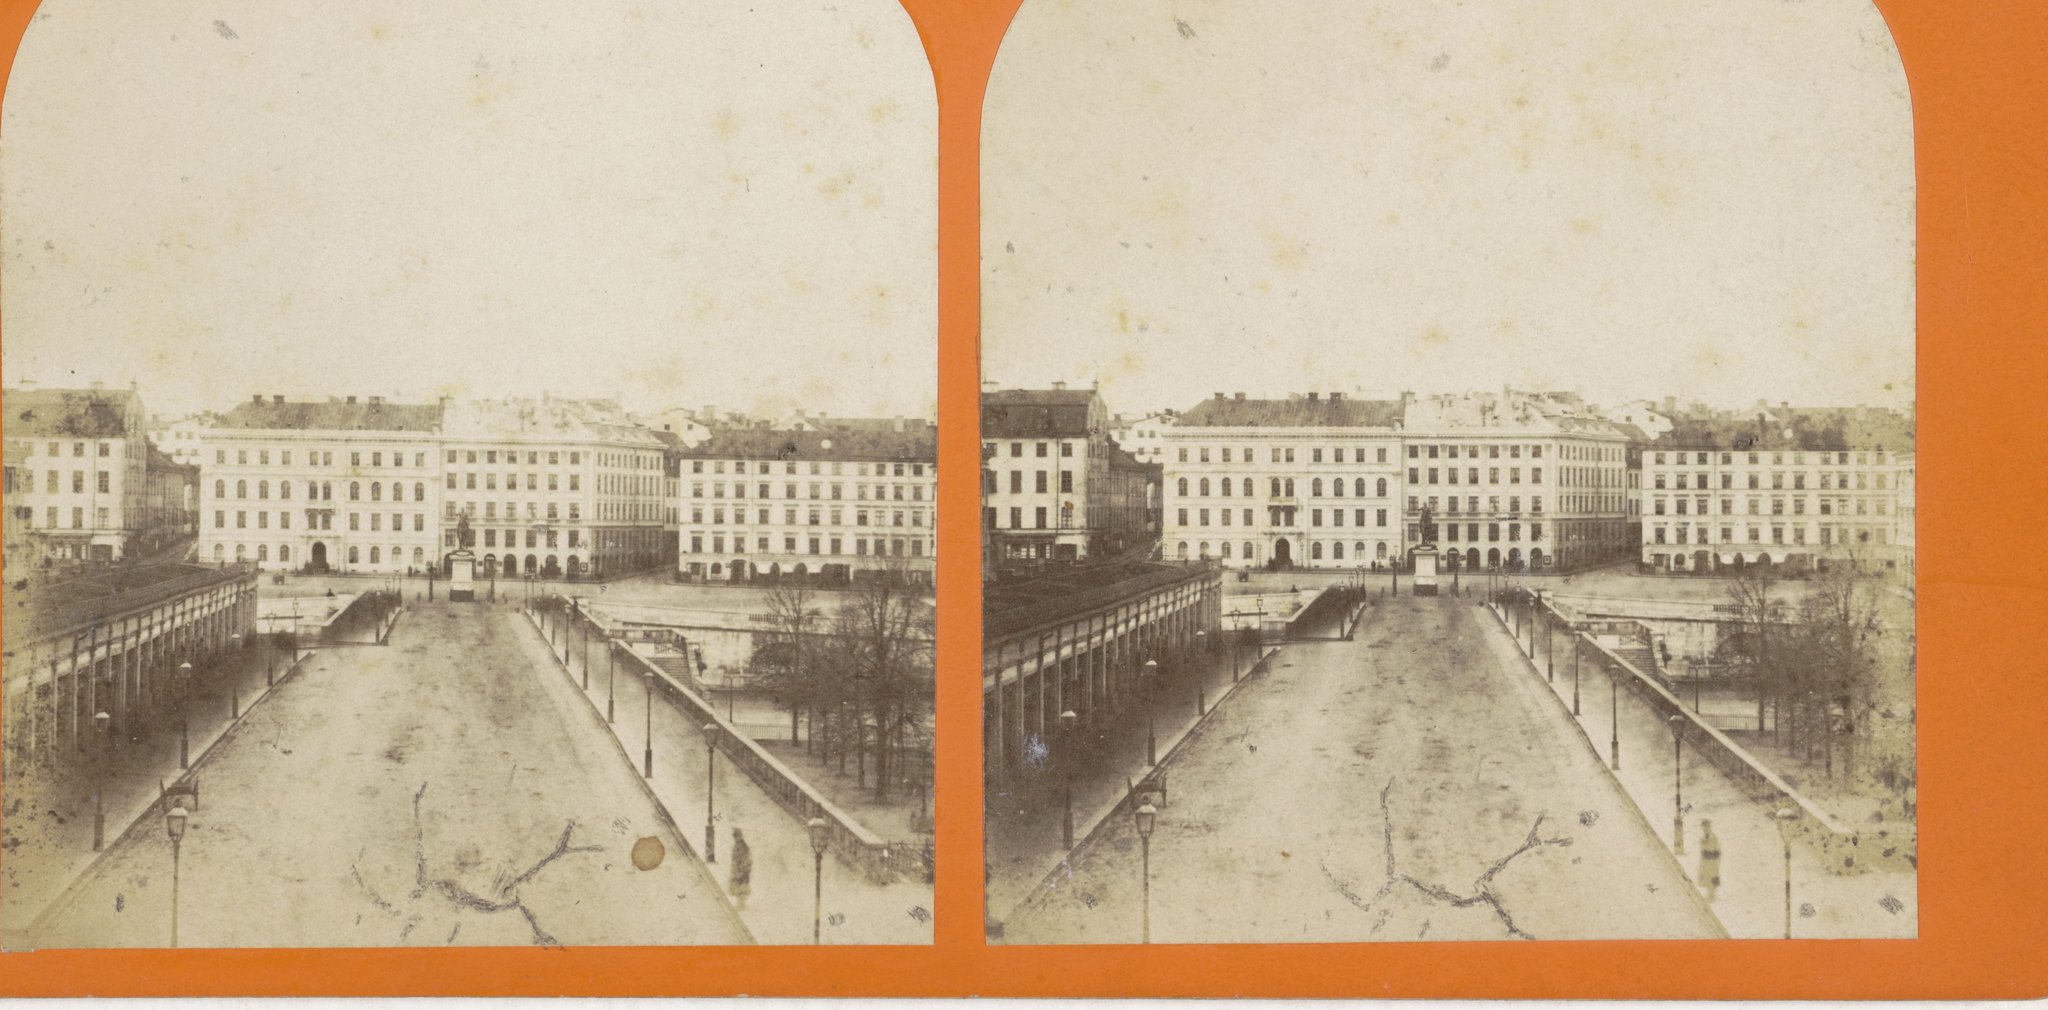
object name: stereograph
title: Gezicht op Gustav Adolfs torg en de de brug bij Norrbro, gezien vanaf Stockholms slot, Stockholm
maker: Anonymous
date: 1868-1880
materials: cardboard, paper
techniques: albumen print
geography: stockholm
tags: bridge, street